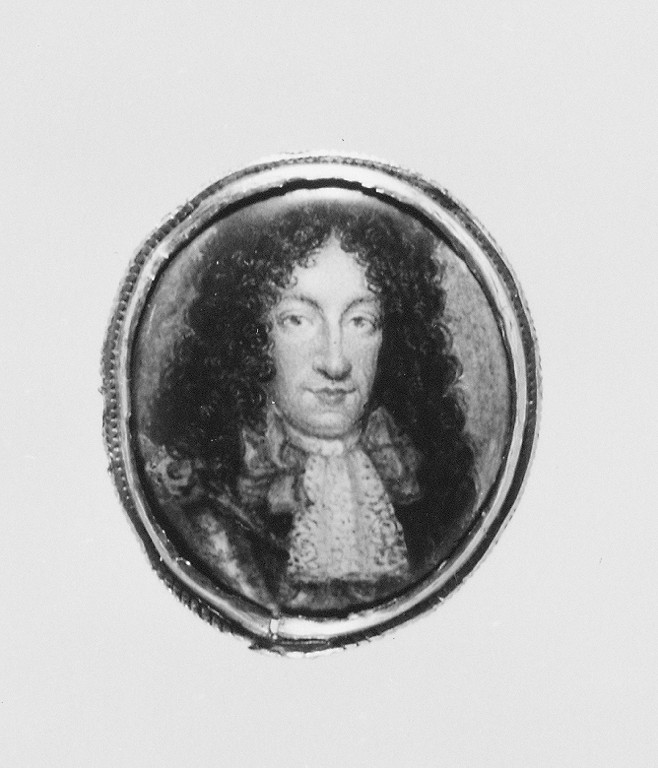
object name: painting, miniature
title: Portrait of a Man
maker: continental painter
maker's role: artist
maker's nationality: continental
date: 1685-1695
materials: enamel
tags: men,portraits